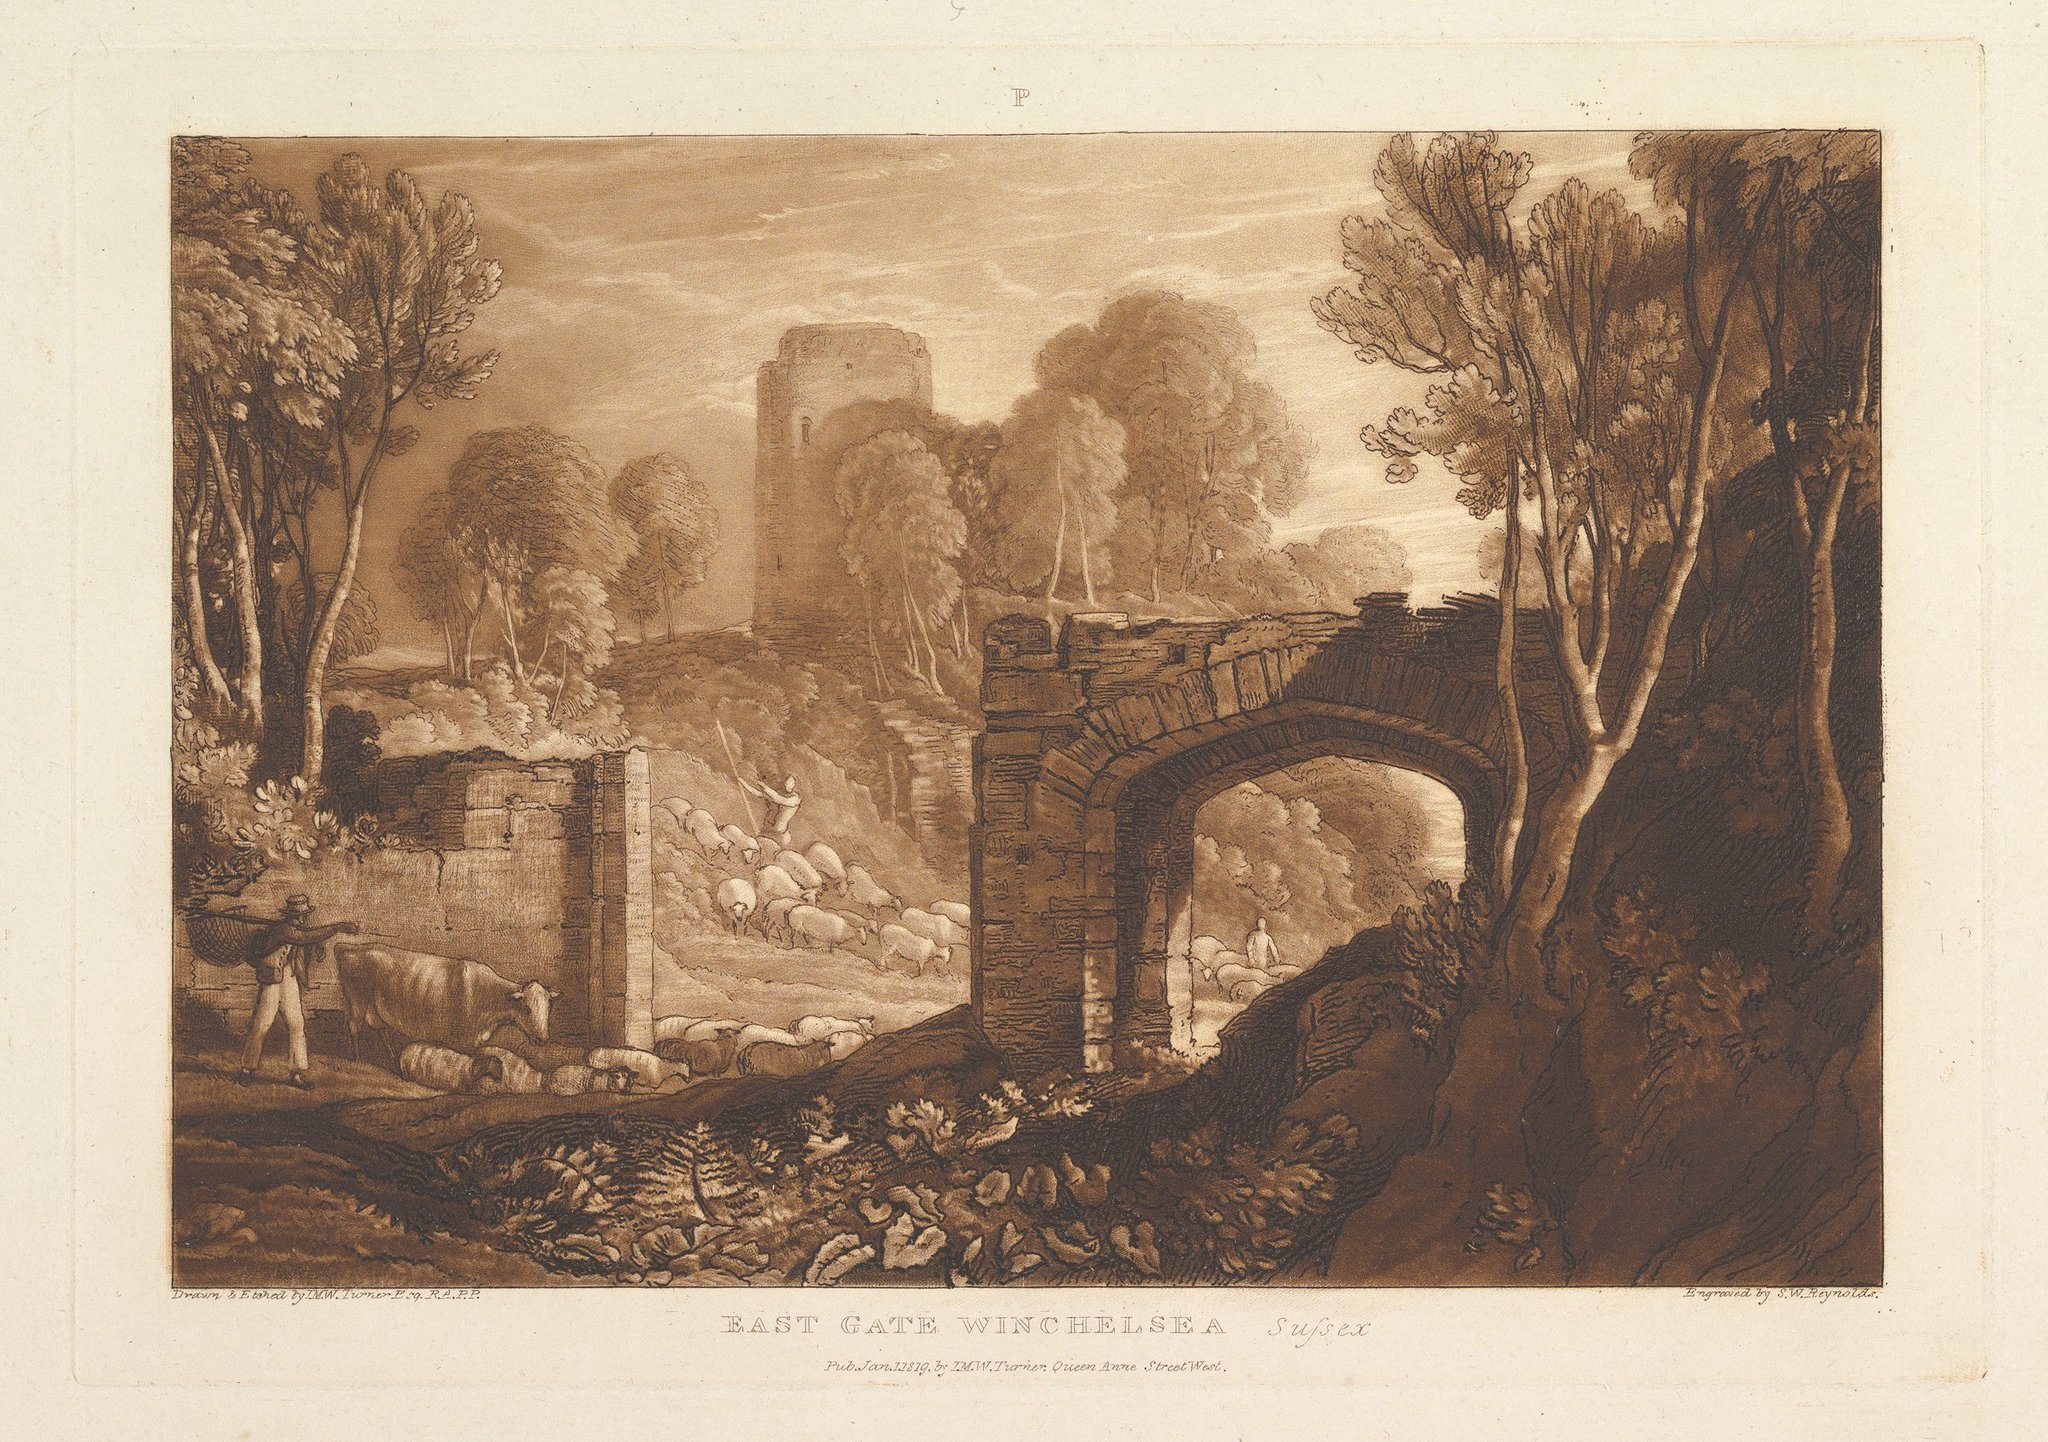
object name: print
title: East Gate, Winchelsea, Sussex, part XIV, plate 67 from "Liber Studiorum"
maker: joseph mallord william turner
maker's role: artist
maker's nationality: british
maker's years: 1775-1851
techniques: etching, mezzotint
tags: human figures,gates,trees